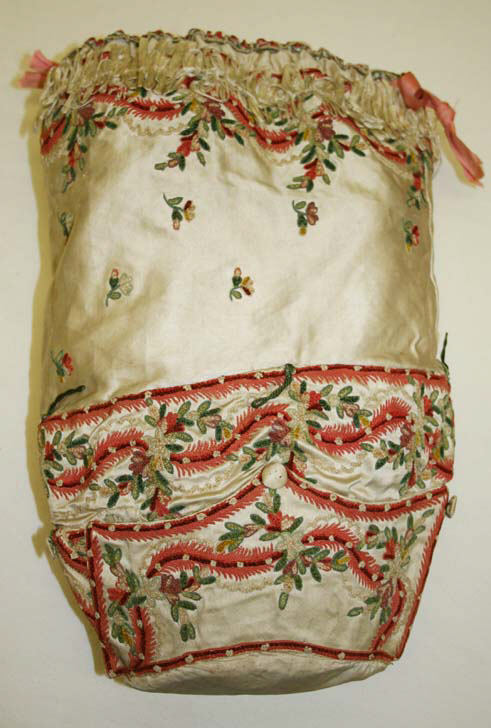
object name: purse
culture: british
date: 1795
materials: silk